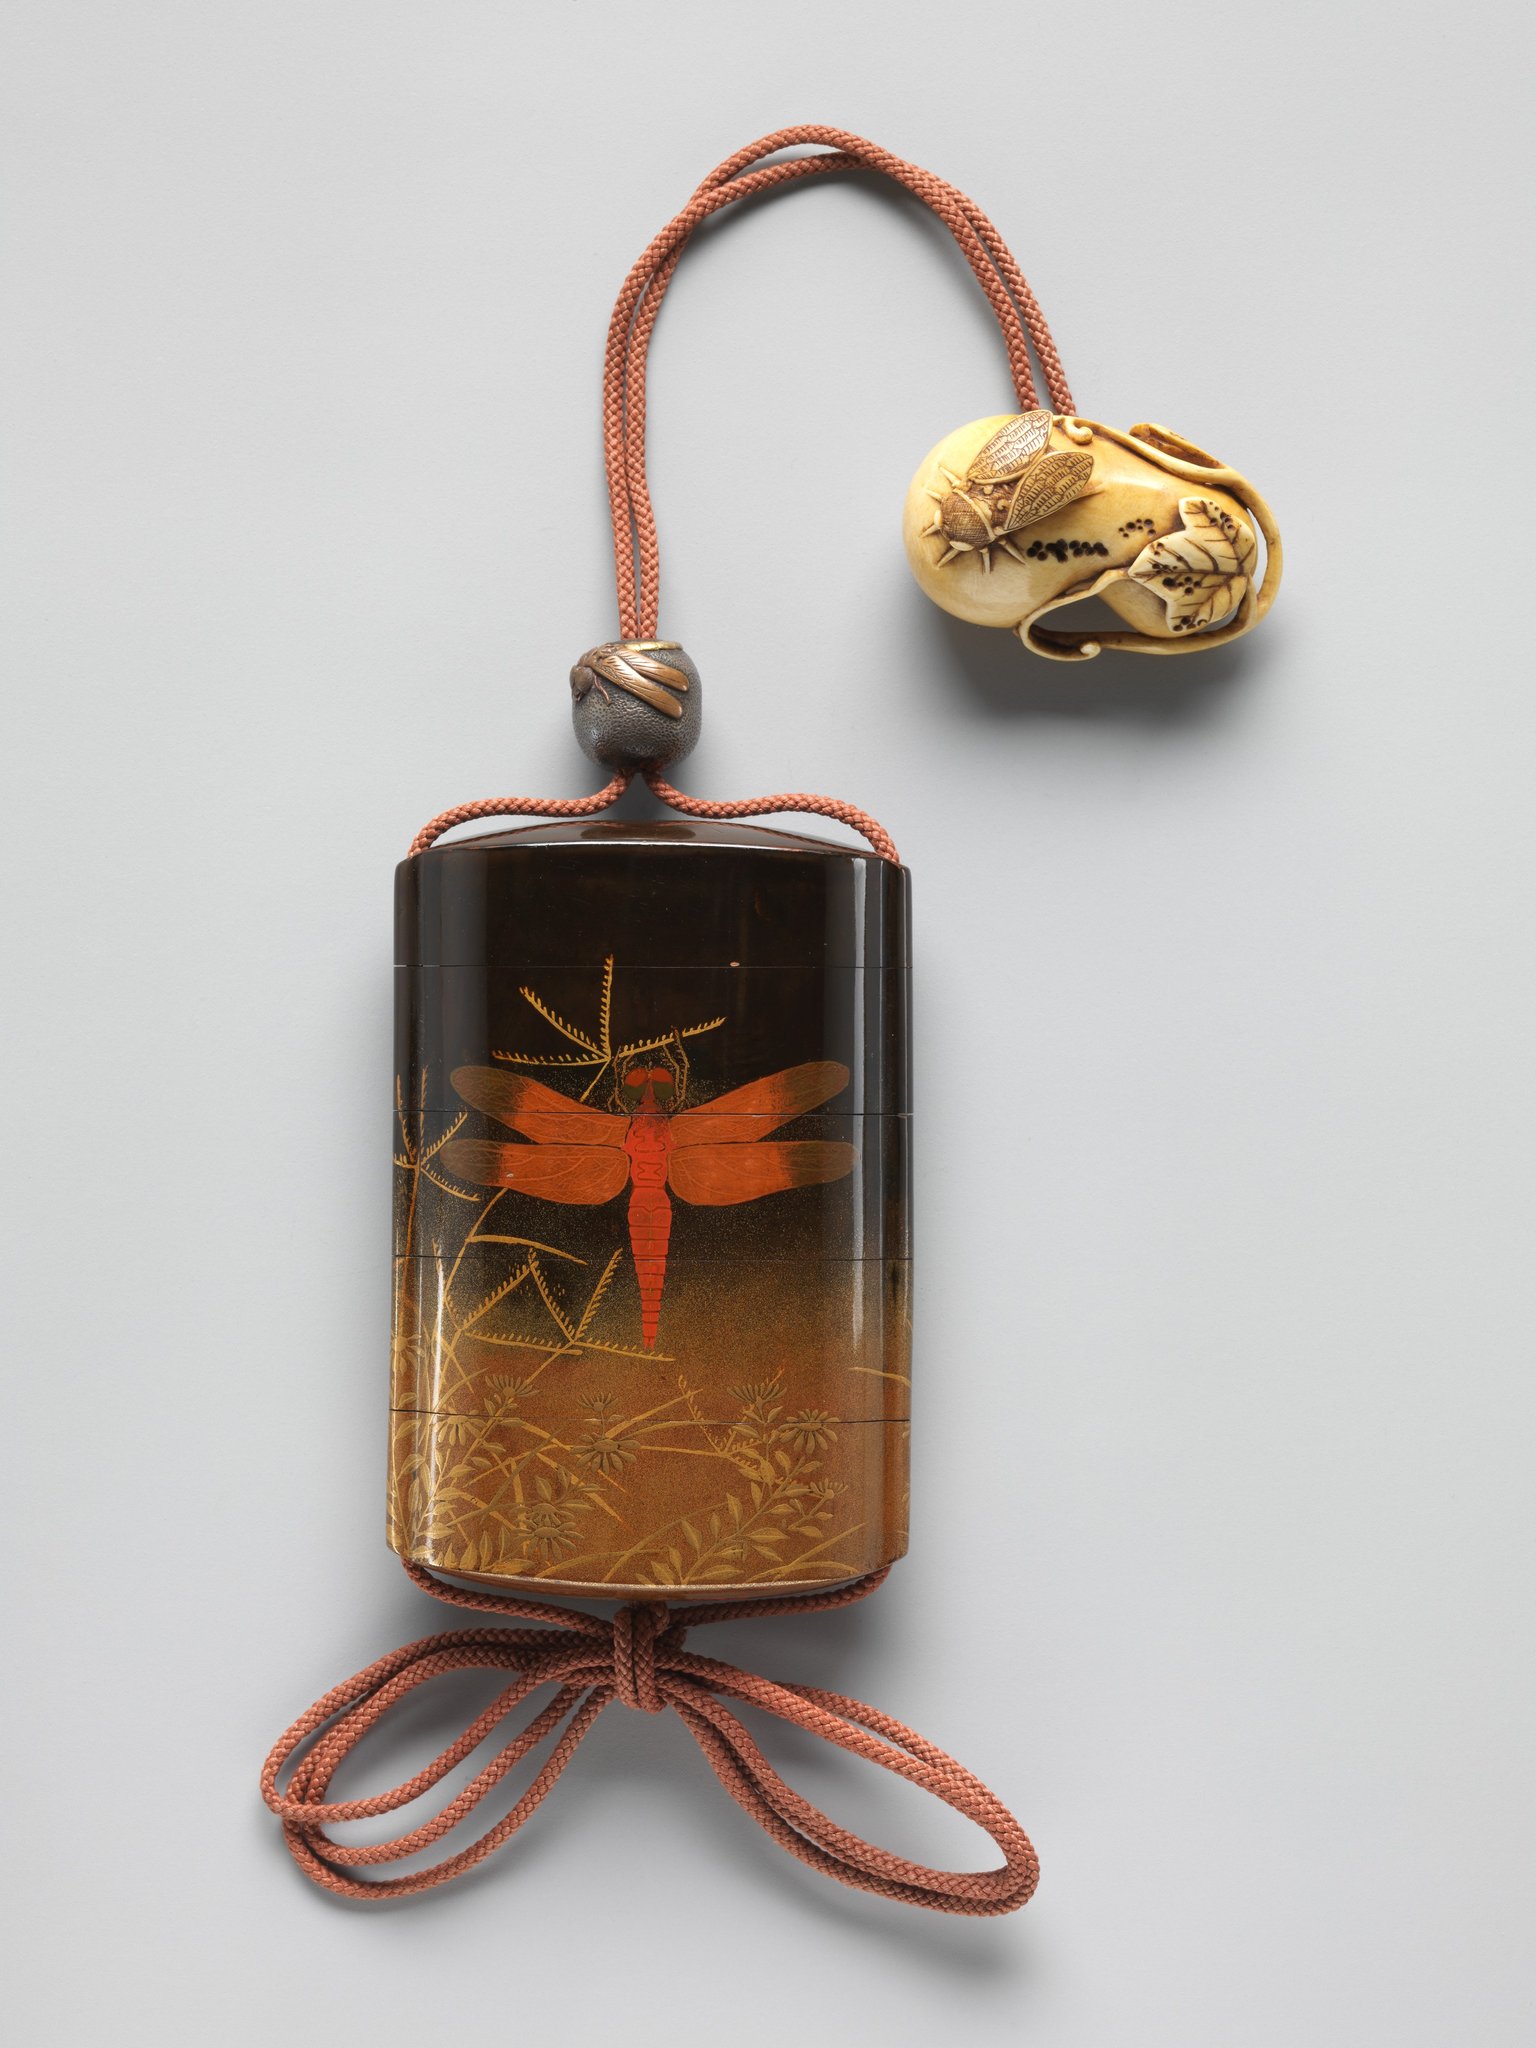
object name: inrō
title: Case (Inrō) with Design of Dragonfly (obverse); Praying Mantis (reverse)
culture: japanese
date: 1801-1900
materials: gold, ivory, lacquer, metal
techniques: carving, maki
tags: dragonflies